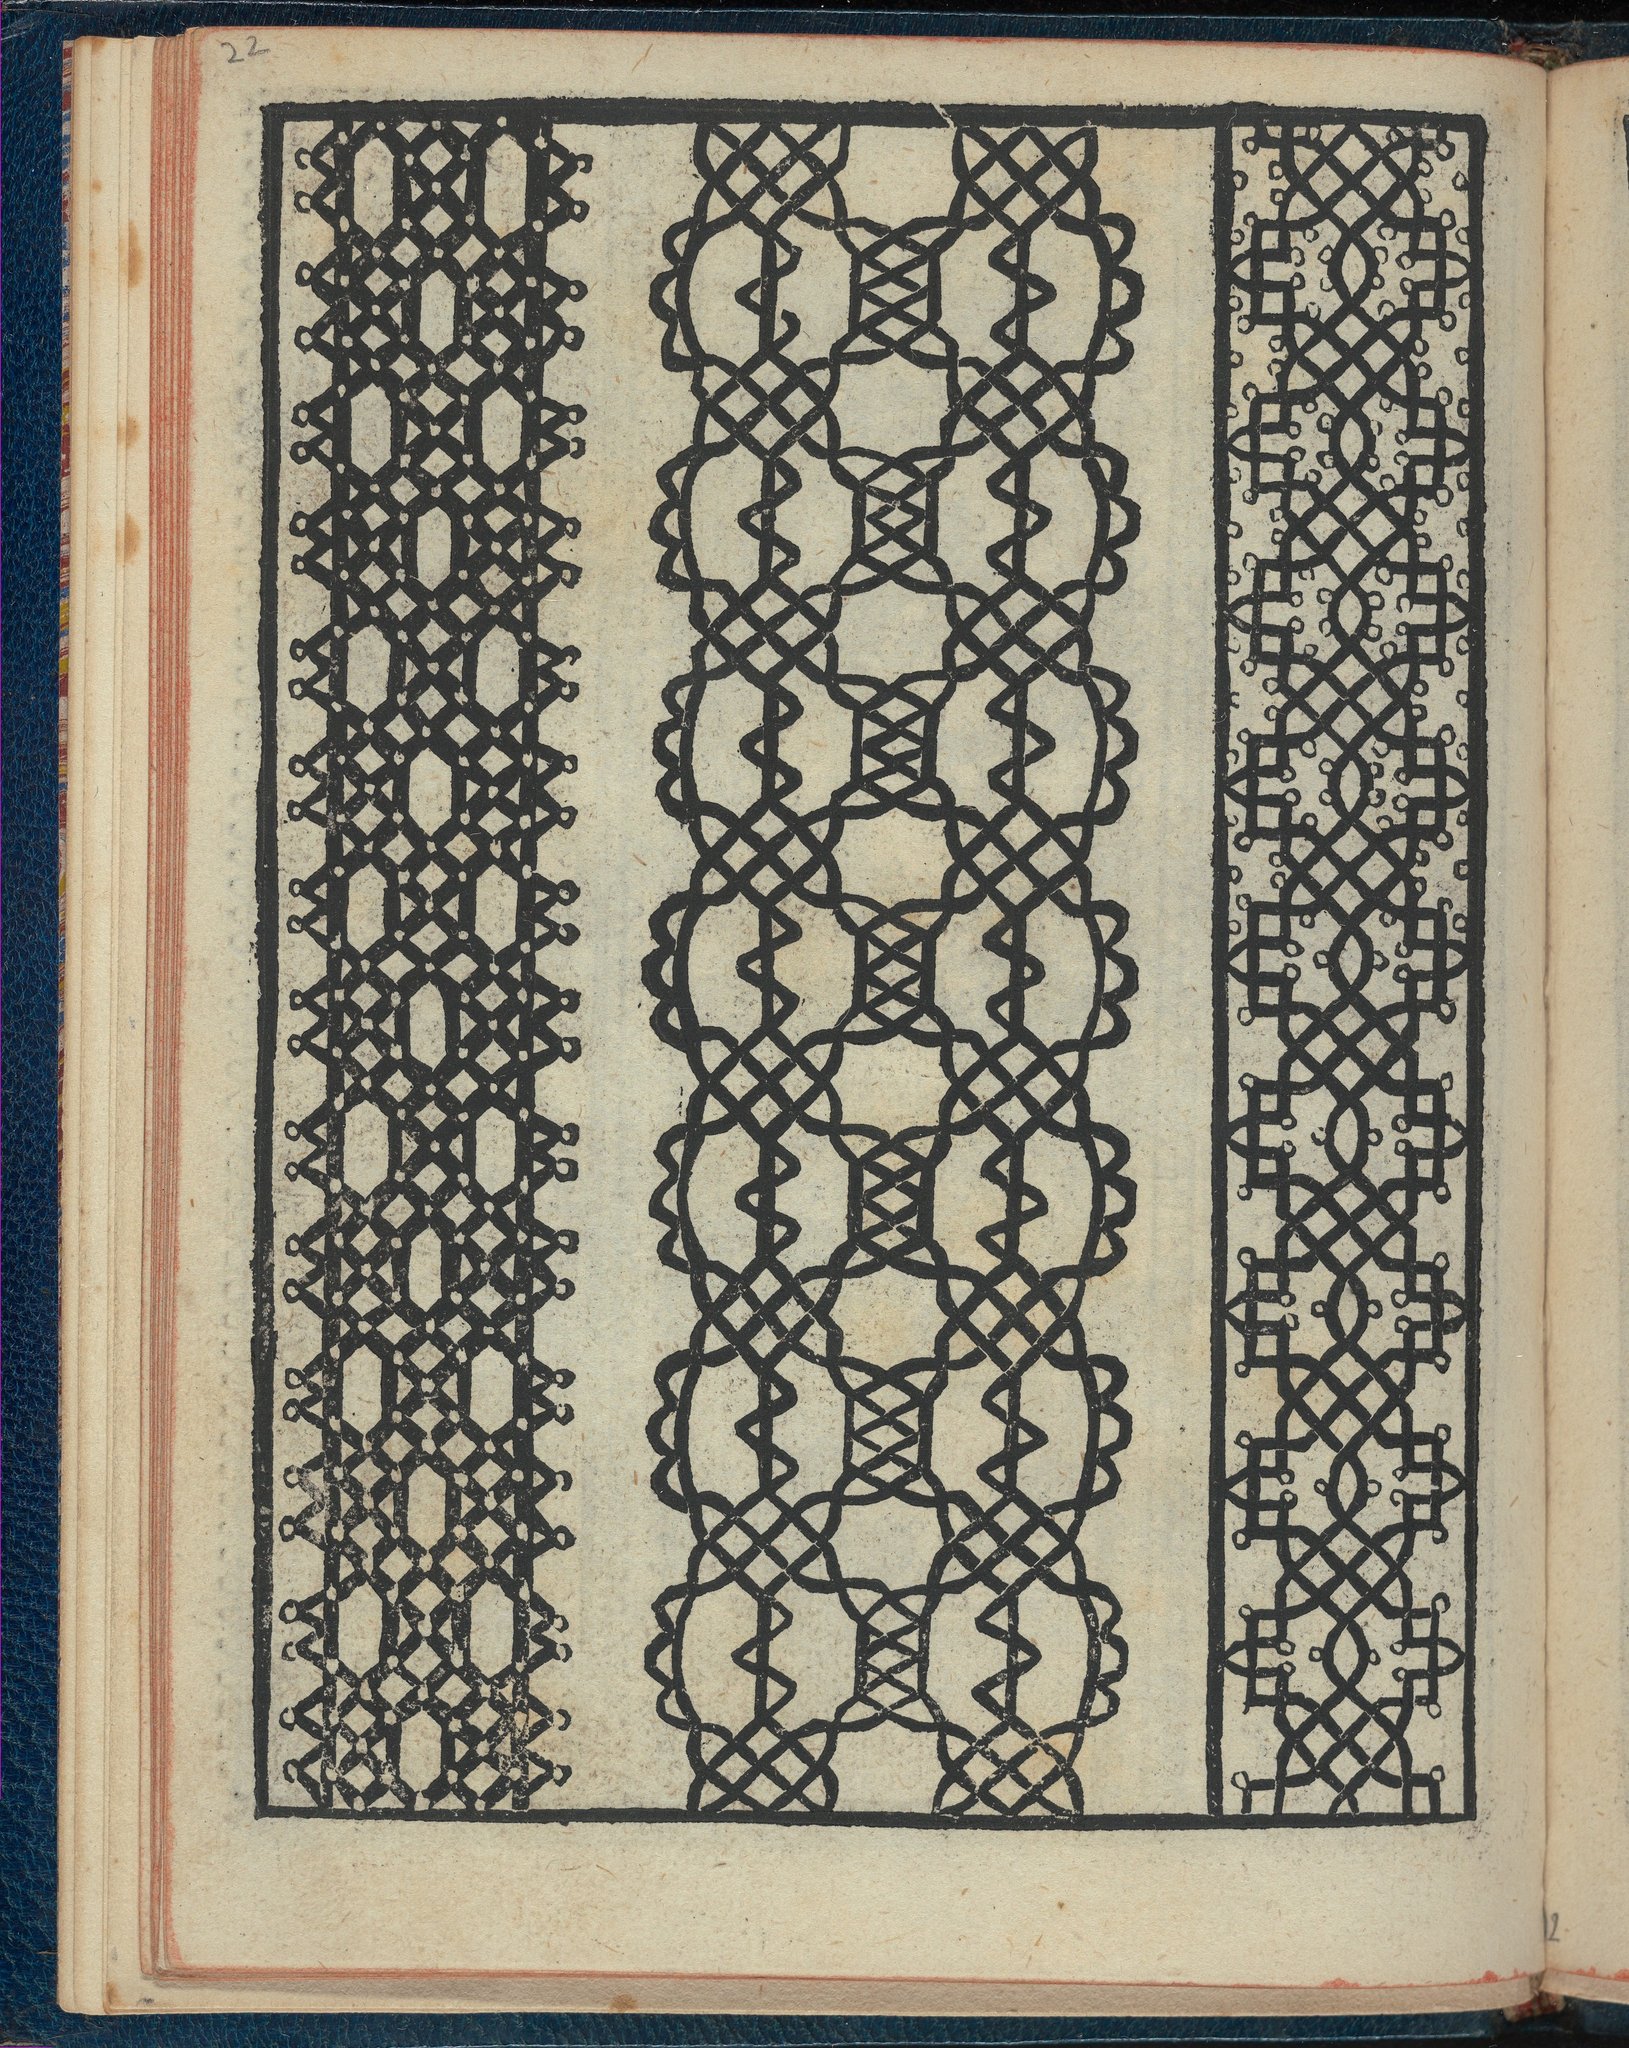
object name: book print ornament architecture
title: Le Pompe: Opera Nova, page 11 (verso)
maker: giovanni battista & marchio sessa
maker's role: publisher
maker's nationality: italian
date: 1557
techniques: woodcut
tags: ornament